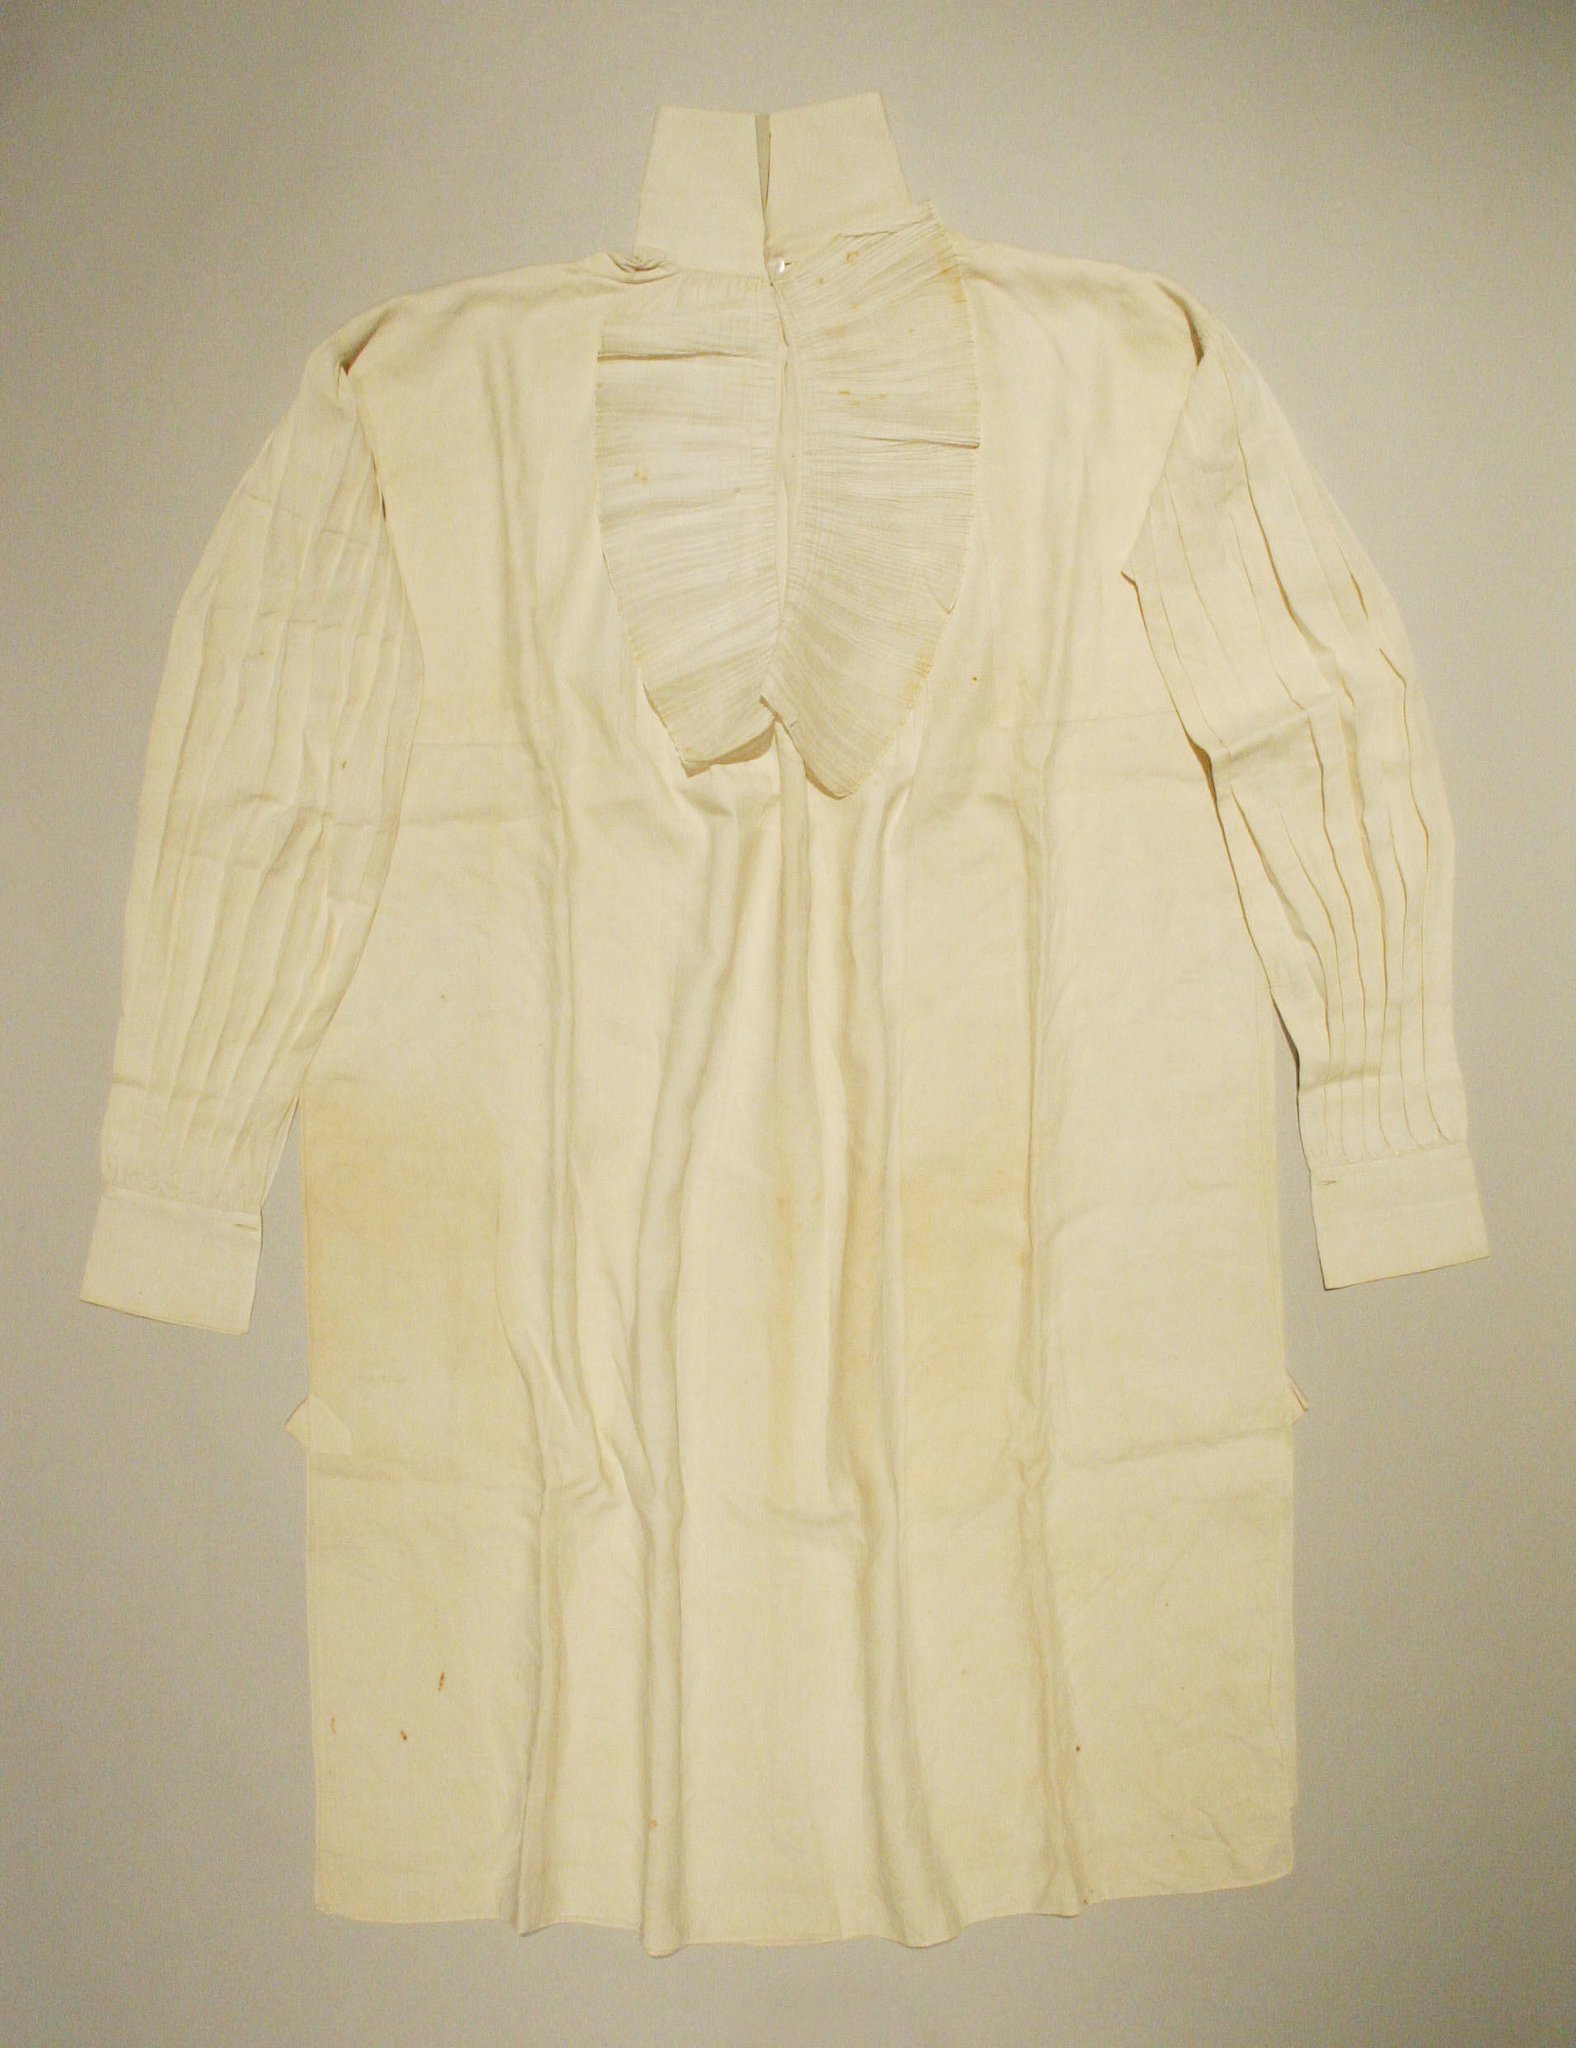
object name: shirt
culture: american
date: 1801-1900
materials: linen